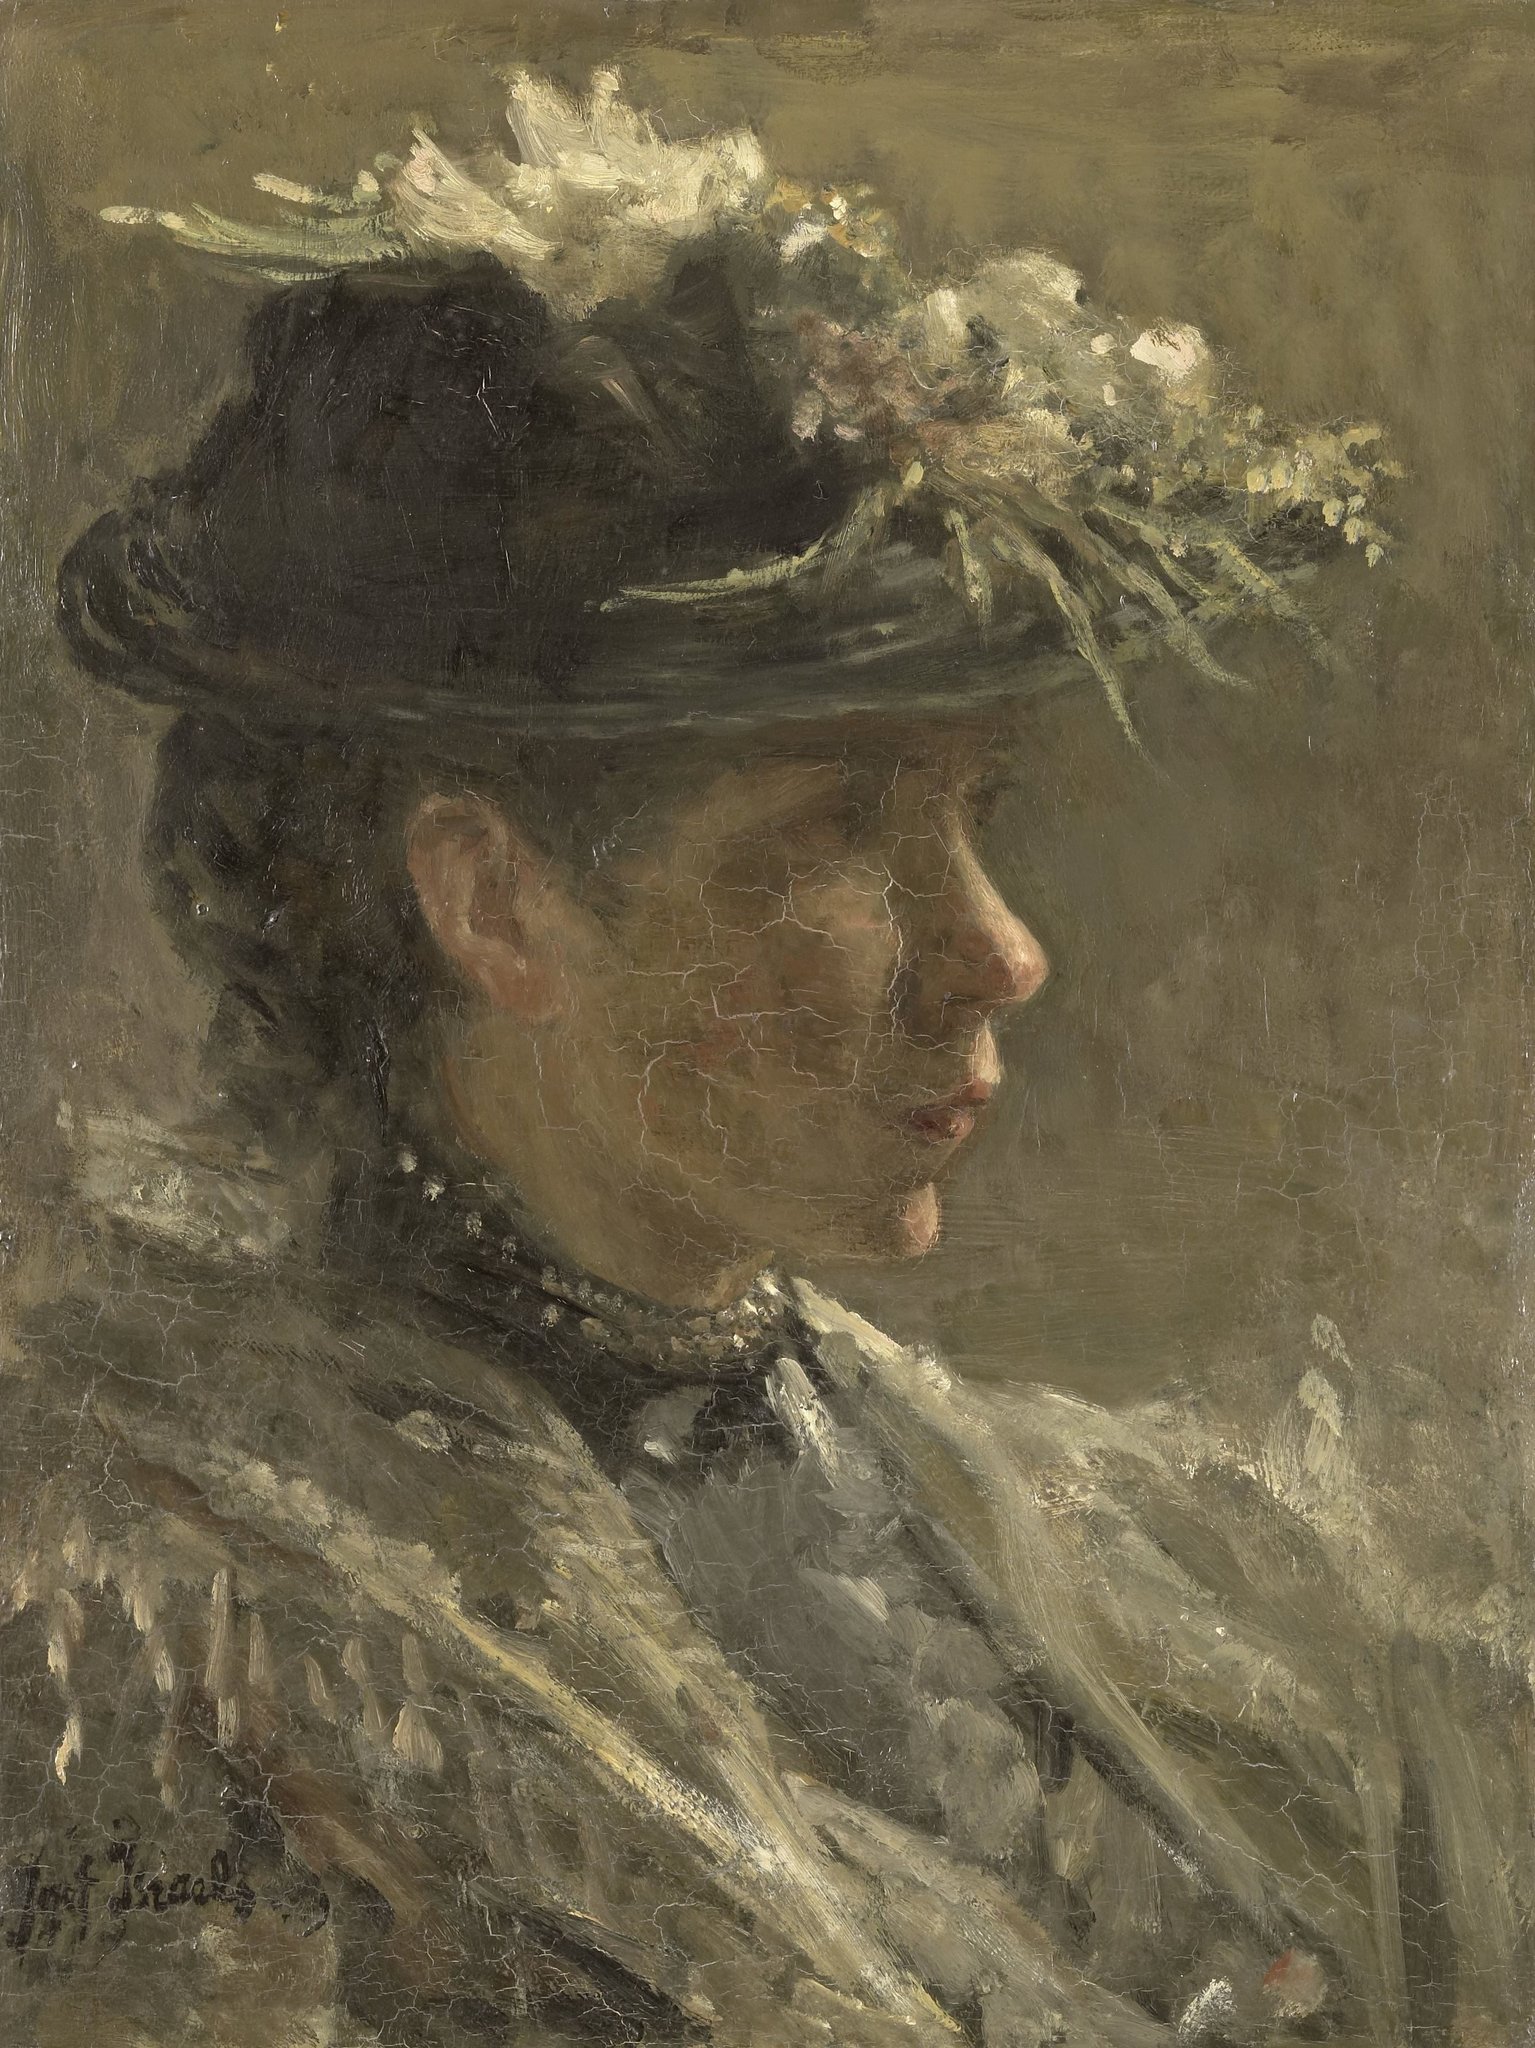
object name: painting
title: Study of a Model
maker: jozef israëls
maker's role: draughtsman, painter, print maker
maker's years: 1824-1911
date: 1896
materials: oil, panel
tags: zeist, historical persons - bb - woman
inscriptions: signature: ‘Jozef Israels’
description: Studie van het model Sijtje van Bemmel, een buurmeisje, op zestienjarige leeftijd. Buste naar rechts met een hoed met bloemen.